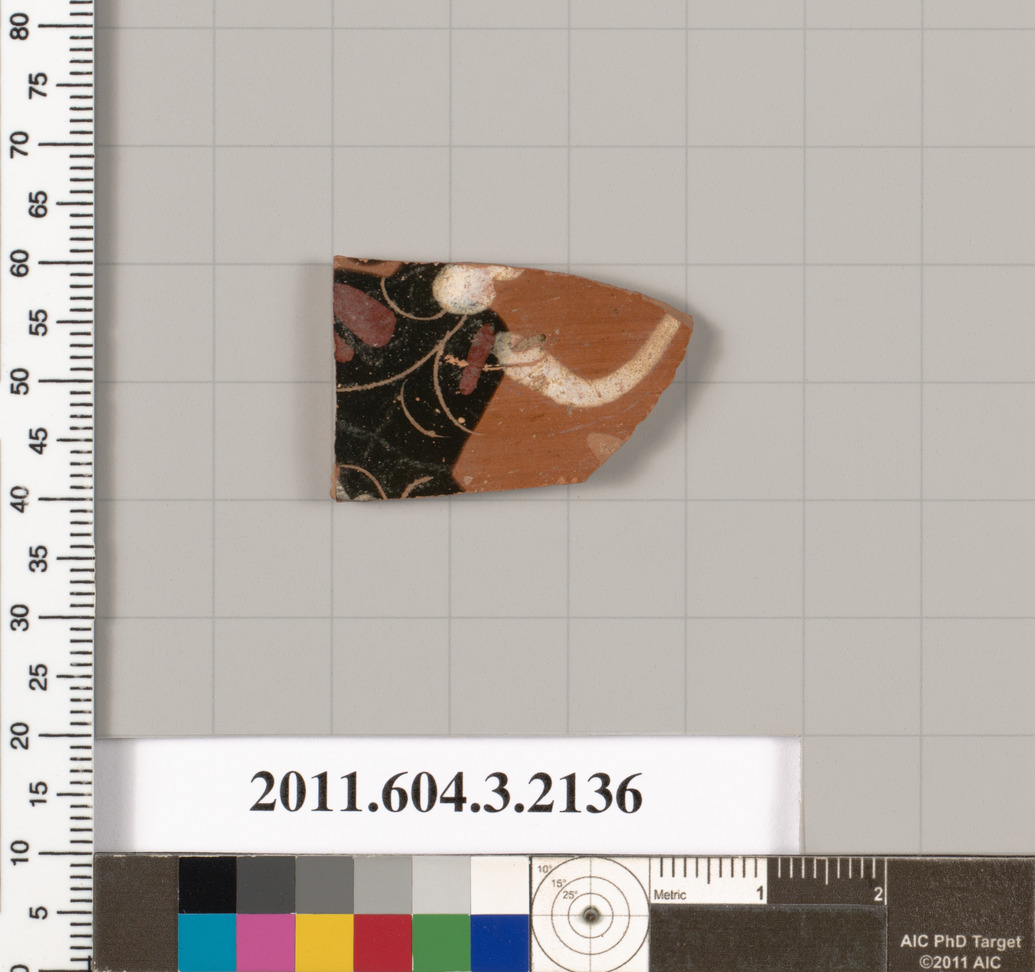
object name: kylix fragment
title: Terracotta fragment of a kylix (drinking cup)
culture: greek, attic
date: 534-501 BCE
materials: terracotta